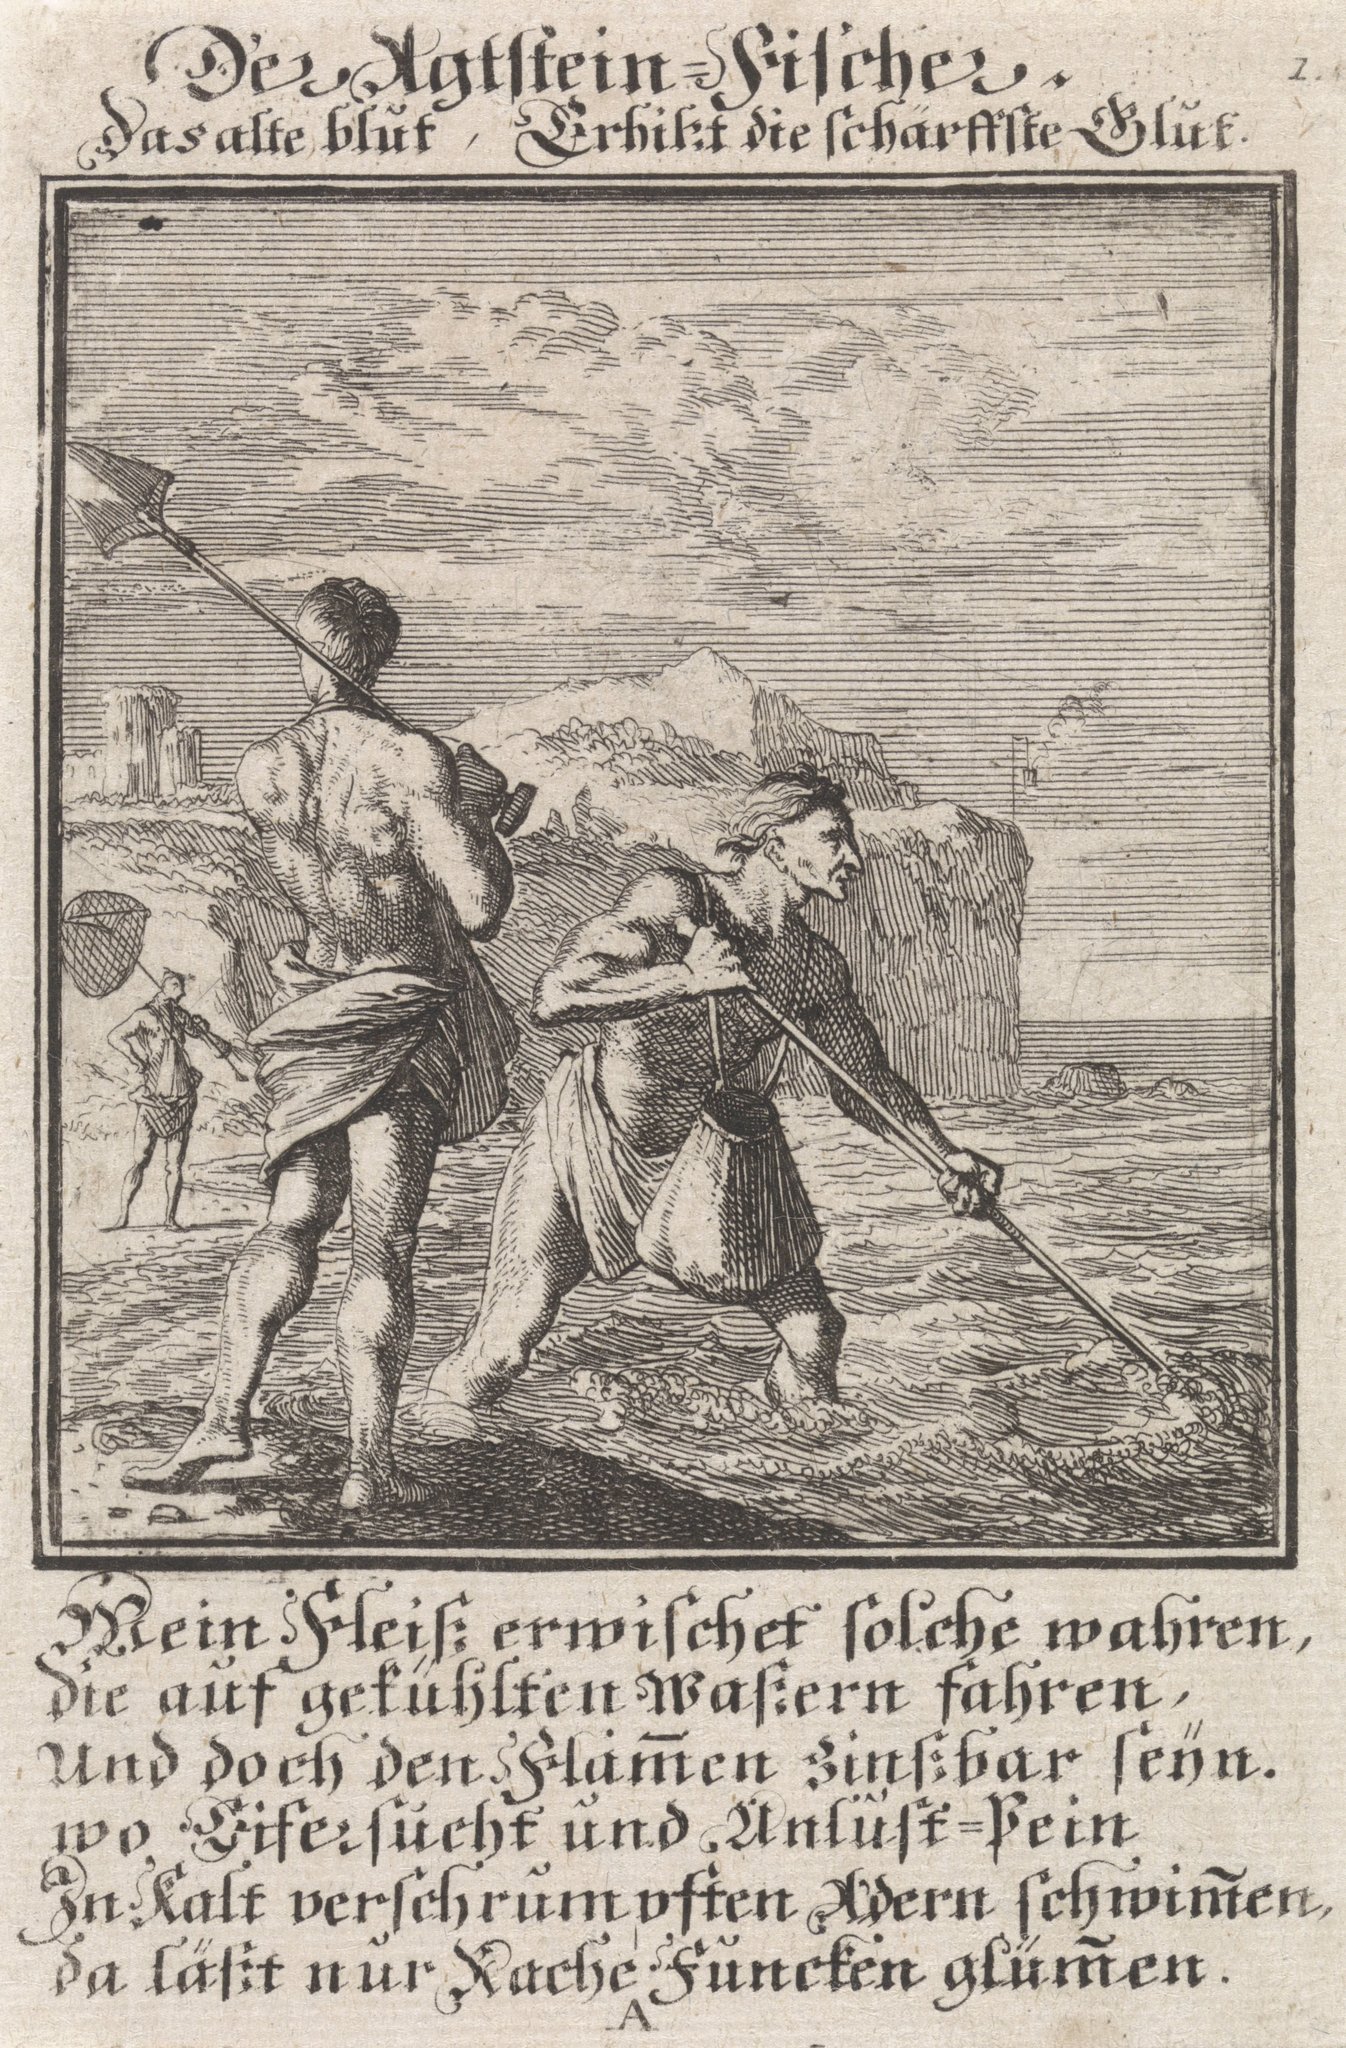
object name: book illustration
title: Der Agtstein-Fischer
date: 1711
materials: paper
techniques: etching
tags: amber (fossil resin), fisherman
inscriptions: collector's mark: Lugt 2228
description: Illustratie uit: Sancta Clara, Abraham à. Etwas für Alle, das ist: Eine kurtze Beschreibung allerley Stands- Ambts- und Gewerbs-Persohnen (...), 3 delen (1699-1733). Würtzburg: Martin Frank Hertz, 1711, dl. II, p. 1. Het betreft hier de tweede druk van deel II.